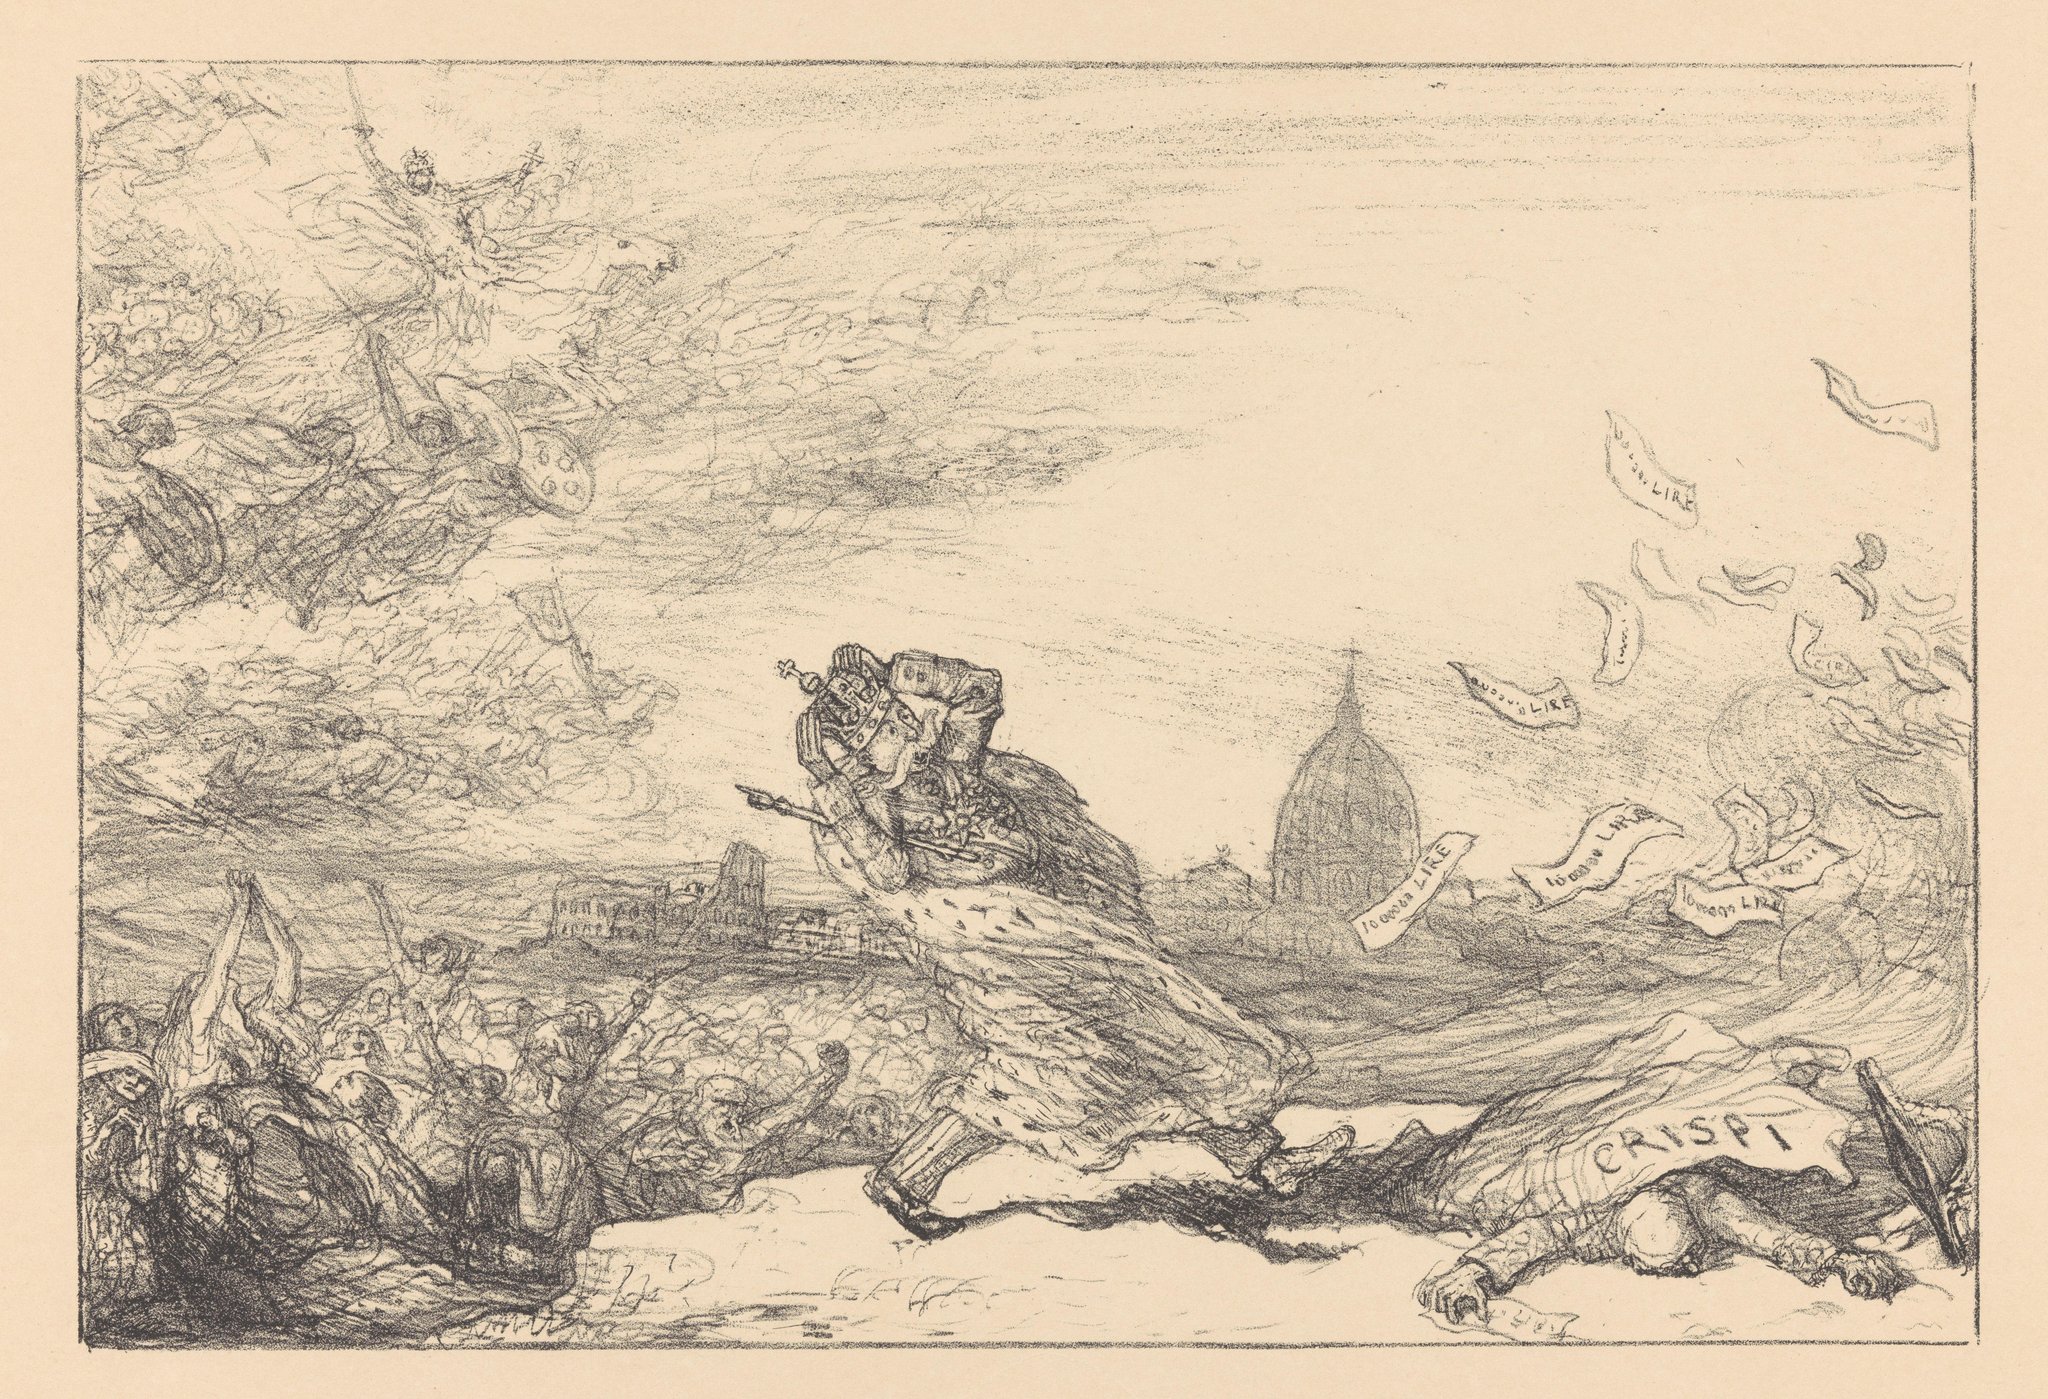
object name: print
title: De sirocco waait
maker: marius bauer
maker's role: draughtsman, print maker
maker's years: 1867-1932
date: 1896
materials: paper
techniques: lithograph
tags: winds, king, political caricatures and satires, italy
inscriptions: collector's mark: Lugt 2228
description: Spotprent op de Italiaanse verliezen in de slag bij Adowa op 1 maart 1896 tijdens de oorlog met Ethiopië (Abessinië). In het midden verliest de Italiaanse koning Umberto I bijna zijn kroon in de wind, rechts ligt verslagen op de grond de Italiaanse premier Franceso Crispi. Links in de wolken de zegevierende Ethiopische Negus. Verschenen in het bijvoegsel van 'De Kroniek' van 15 maart 1896.